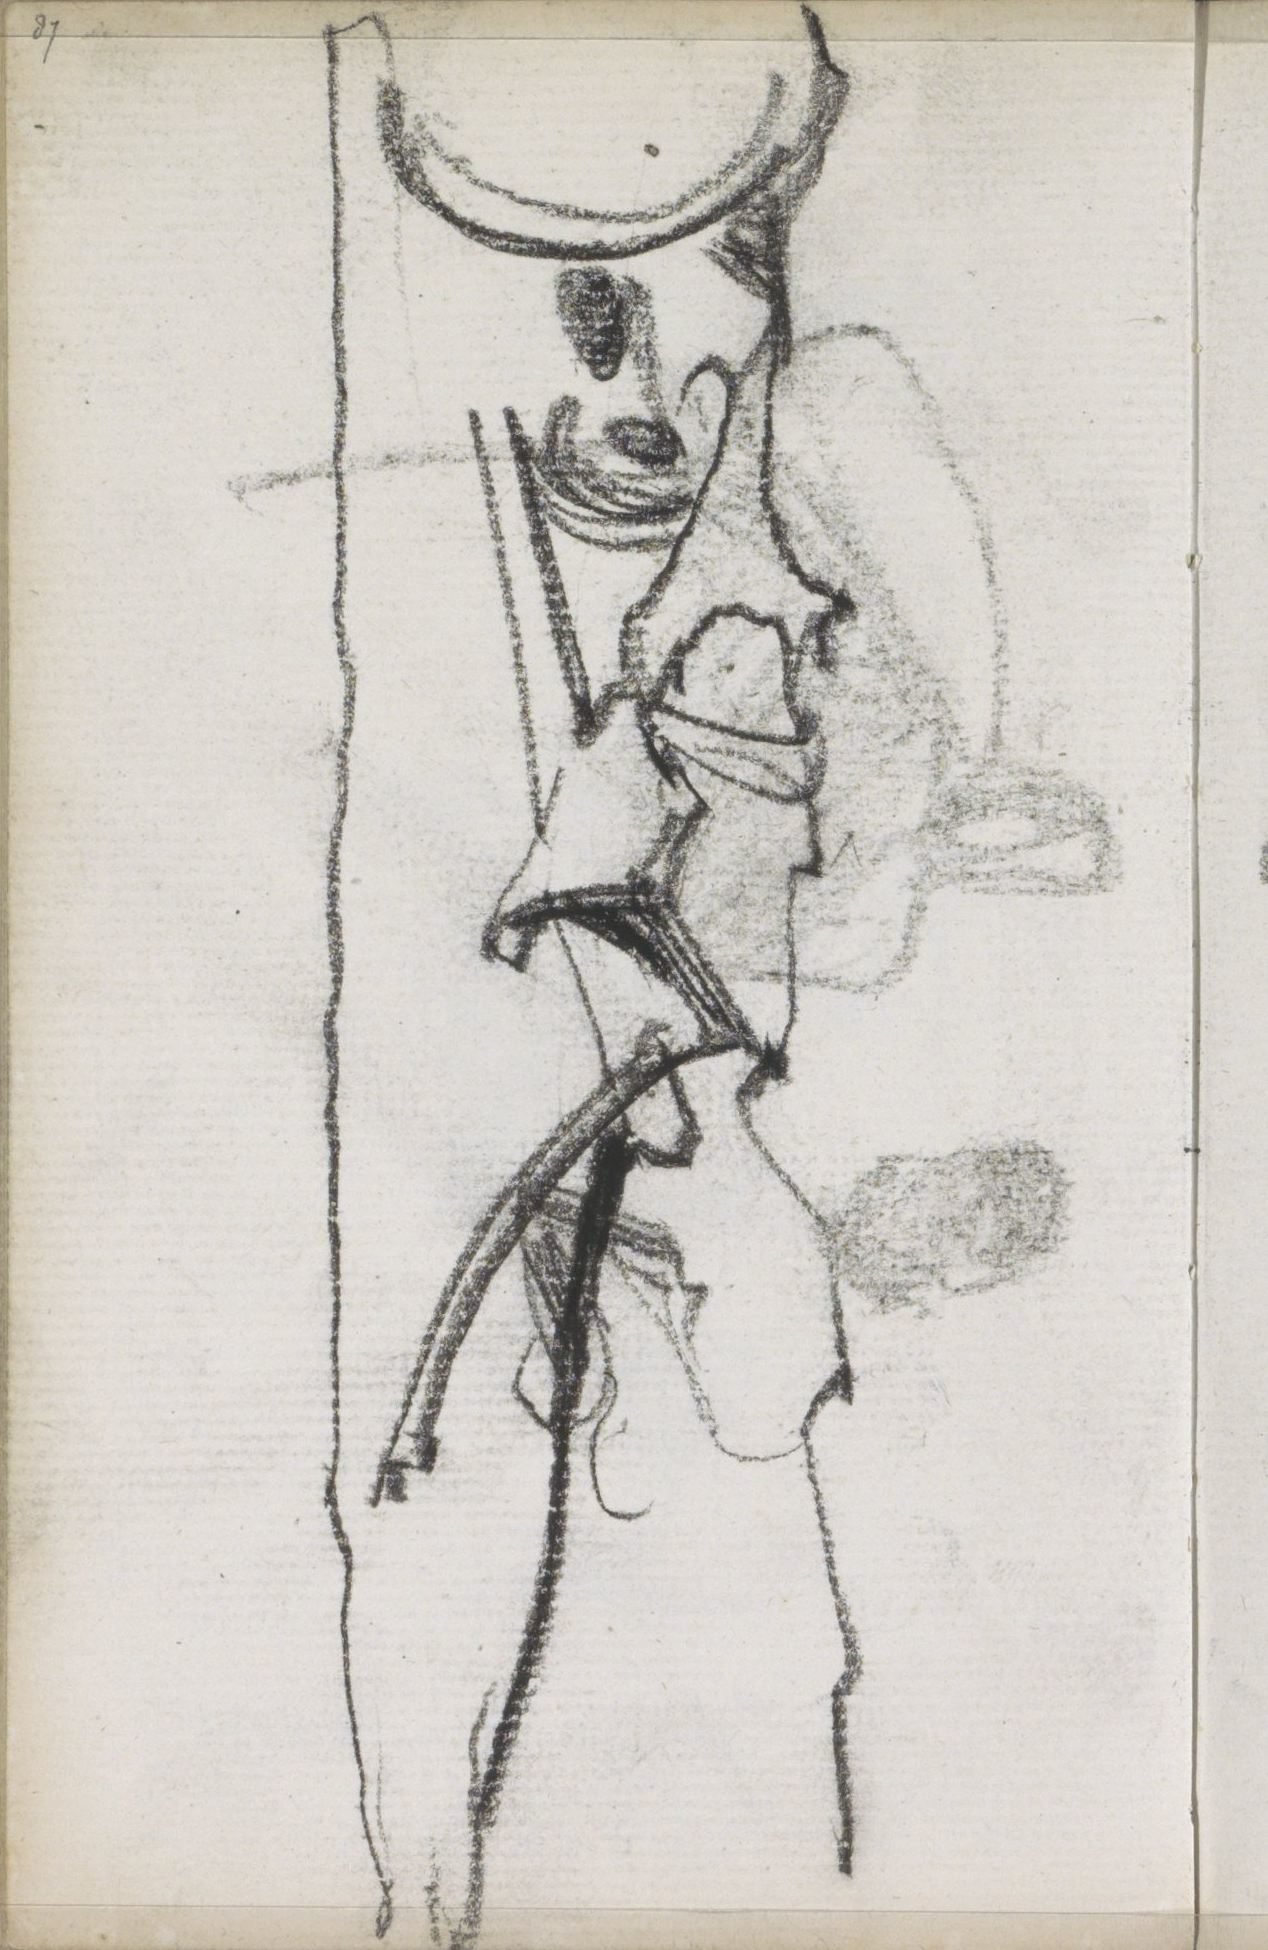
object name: sketchbook leaf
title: Ploeg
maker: george hendrik breitner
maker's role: draughtsman, painter, print maker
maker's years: 1857-1923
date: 1884-1886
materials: chalk, paper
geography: drenthe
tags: agricultural implements: plough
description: Pagina 87 uit een schetsboek met 67 bladen vervaardigd in Drenthe.